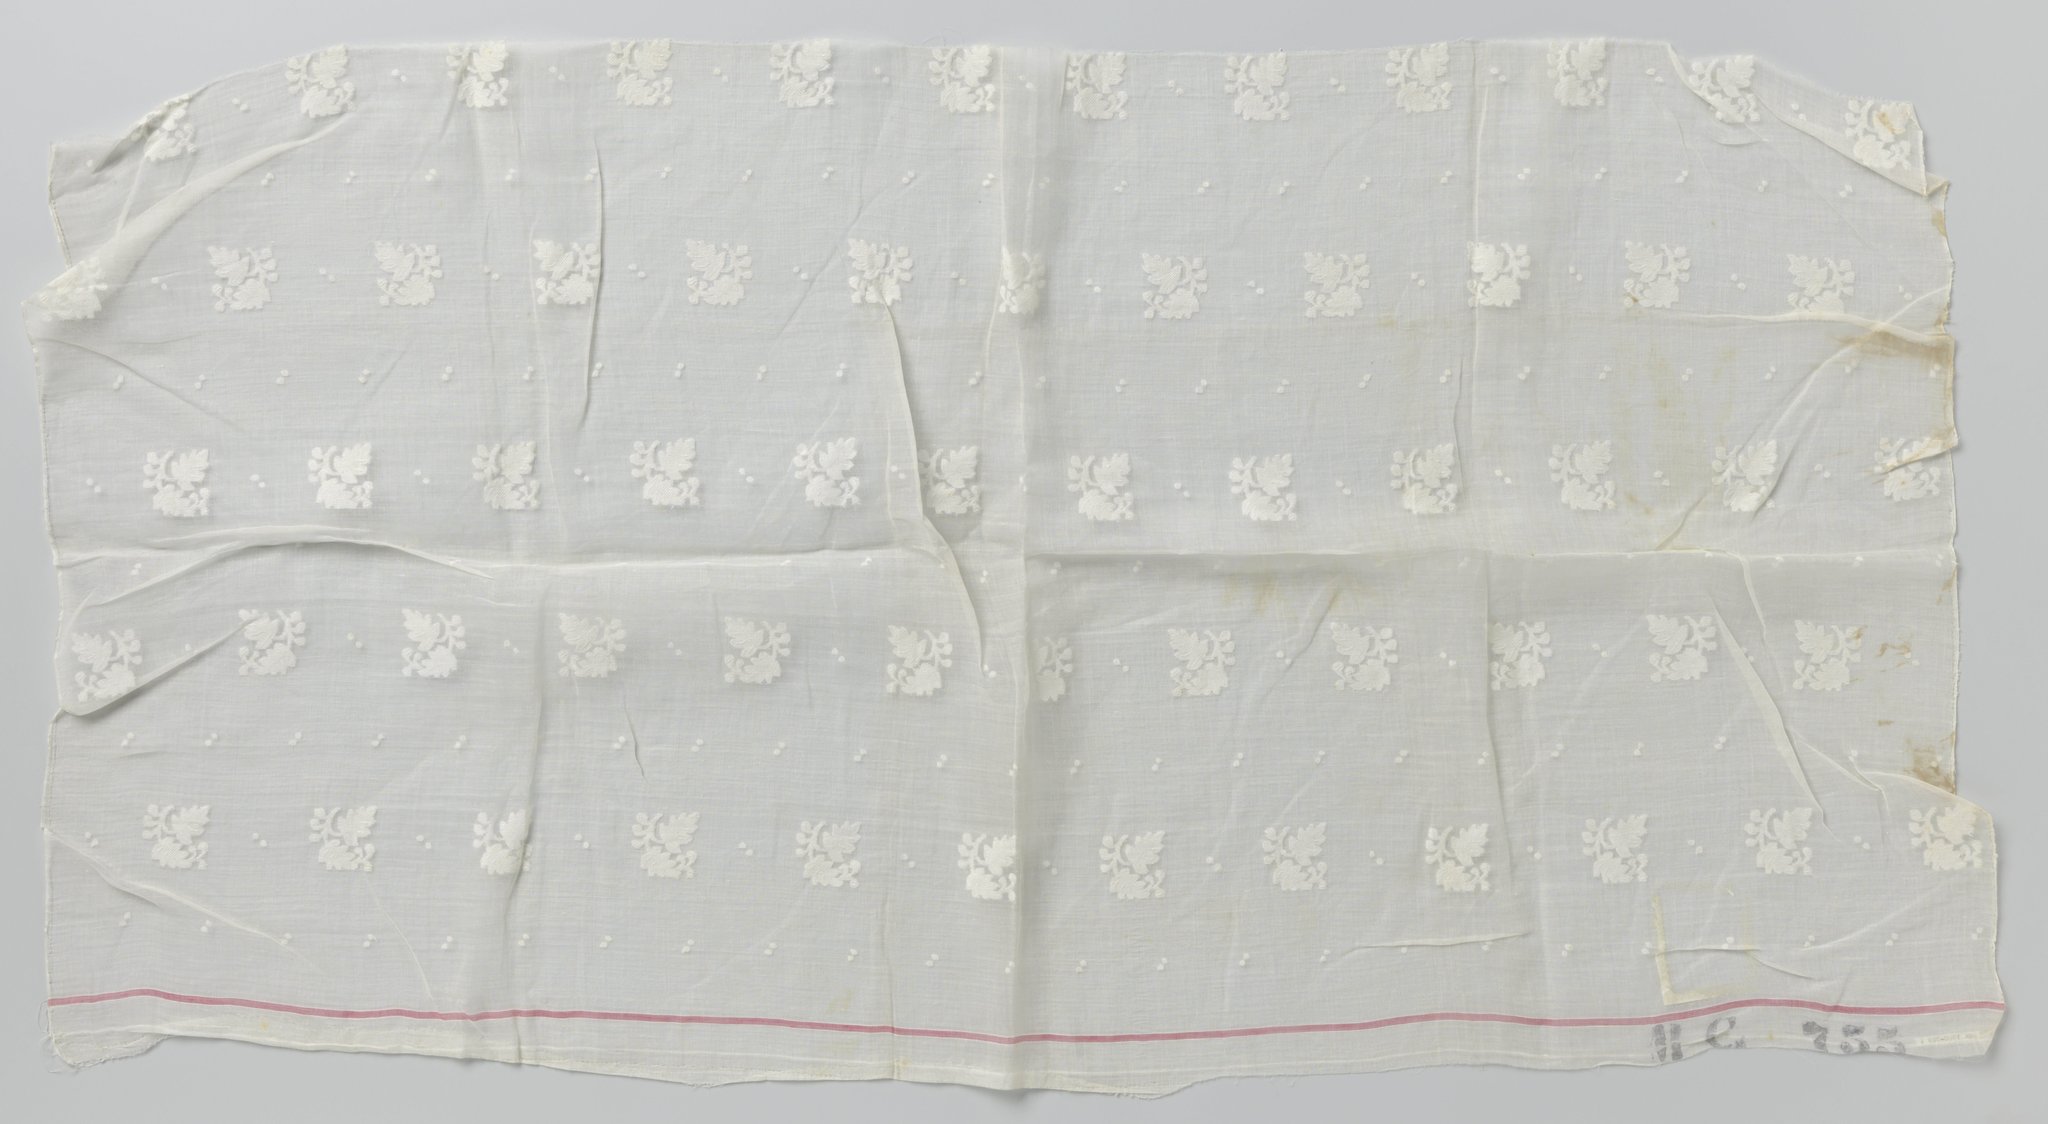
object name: fragment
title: Fragment batist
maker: Anonymous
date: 1800-1920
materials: textile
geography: netherlands